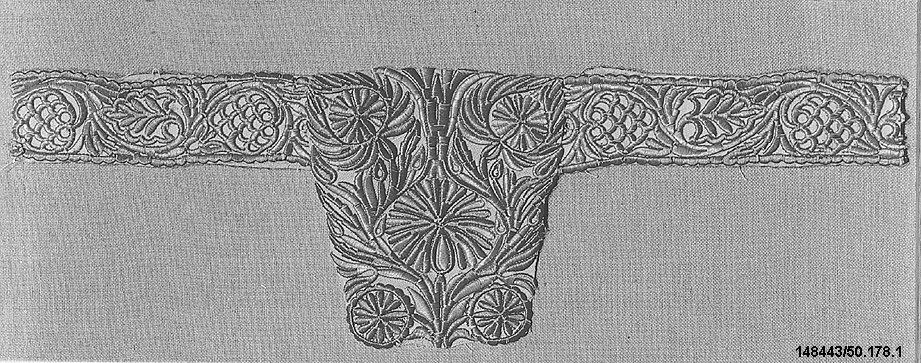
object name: piece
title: Piece (three joined pieces)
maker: nytra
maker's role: manufactory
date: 1801-1850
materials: metal thread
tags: flowers